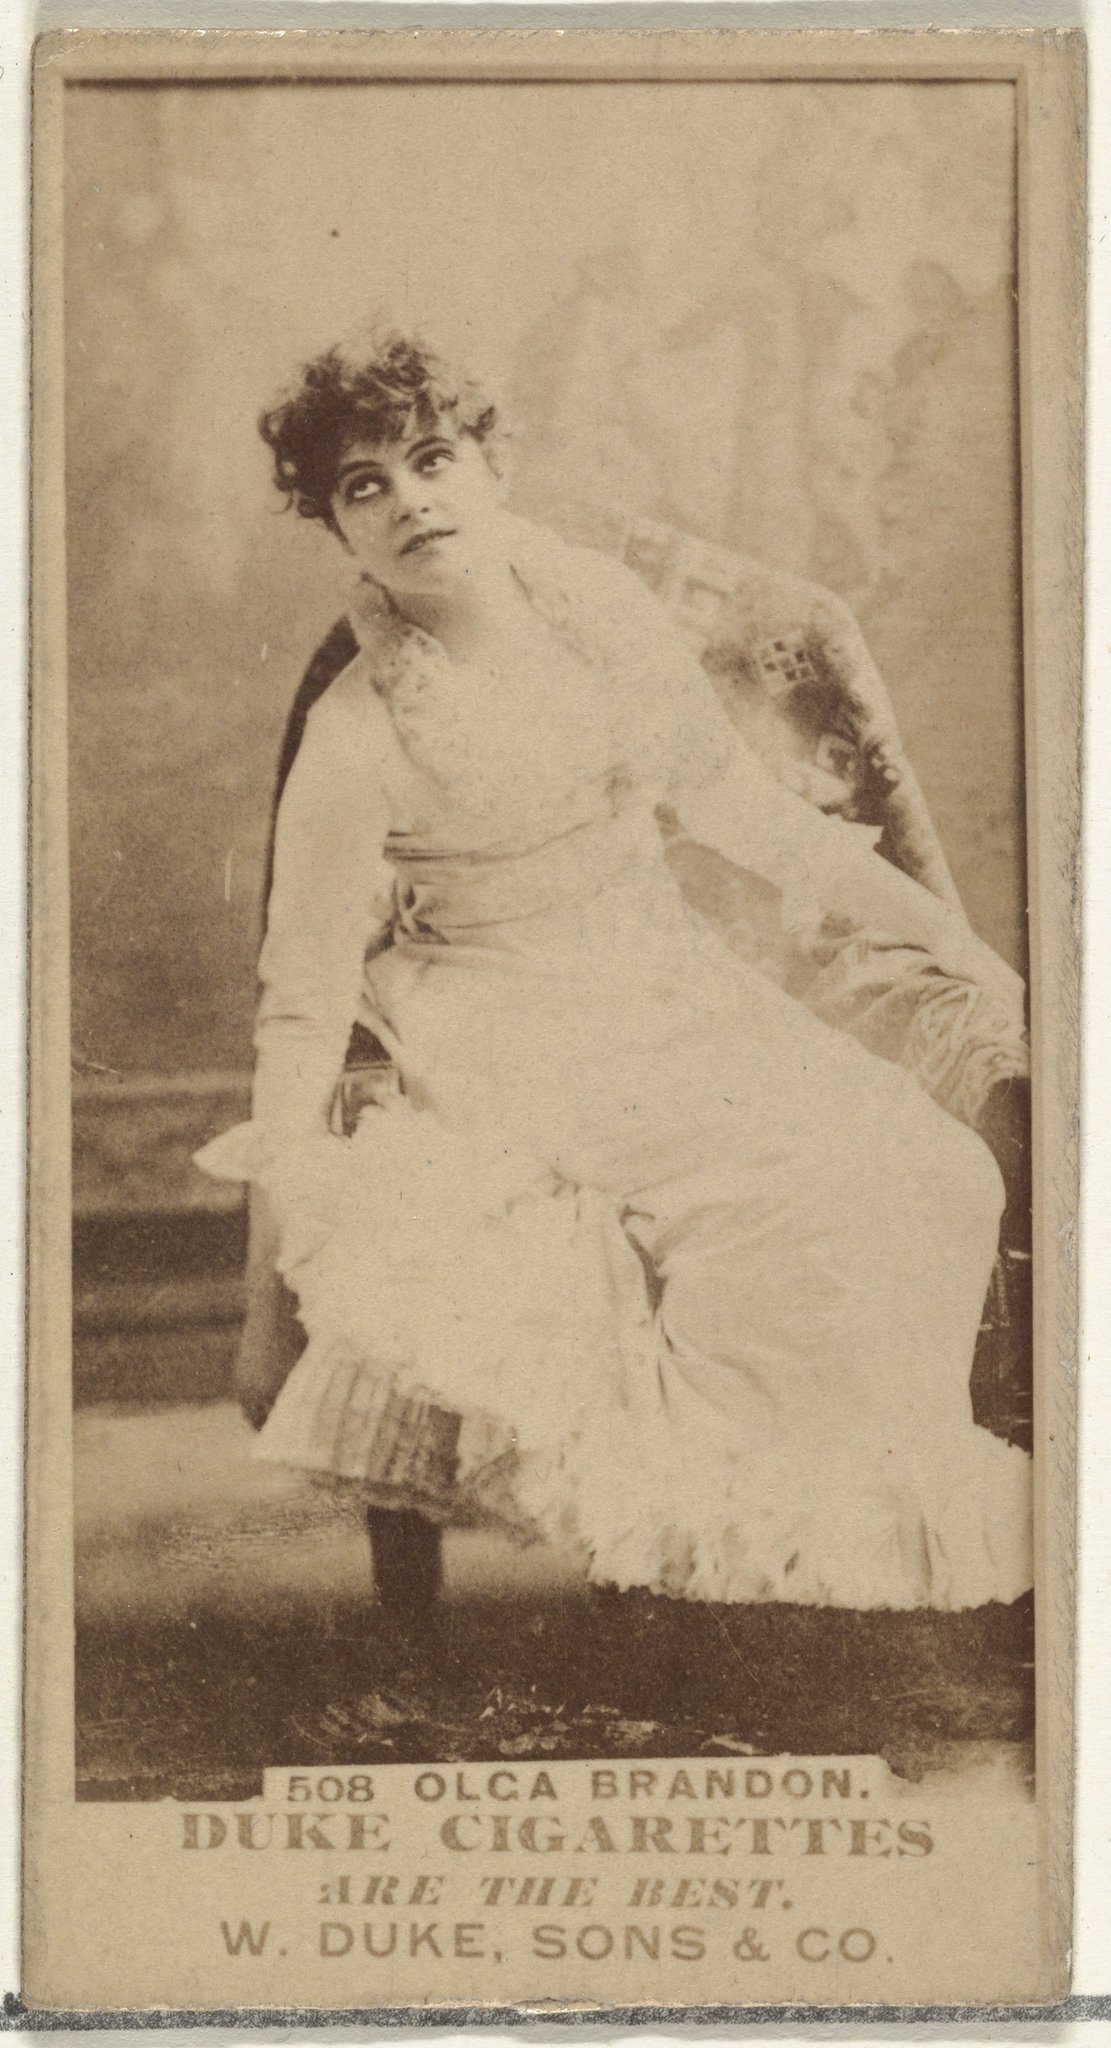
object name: photograph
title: Card Number 508, Olga Brandon, from the Actors and Actresses series (N145-7) issued by Duke Sons & Co. to promote Duke Cigarettes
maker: w. duke, sons & co.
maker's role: publisher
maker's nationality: american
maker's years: 1870-1920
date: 1880-1889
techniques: albumen silver print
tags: portraits,women,actresses